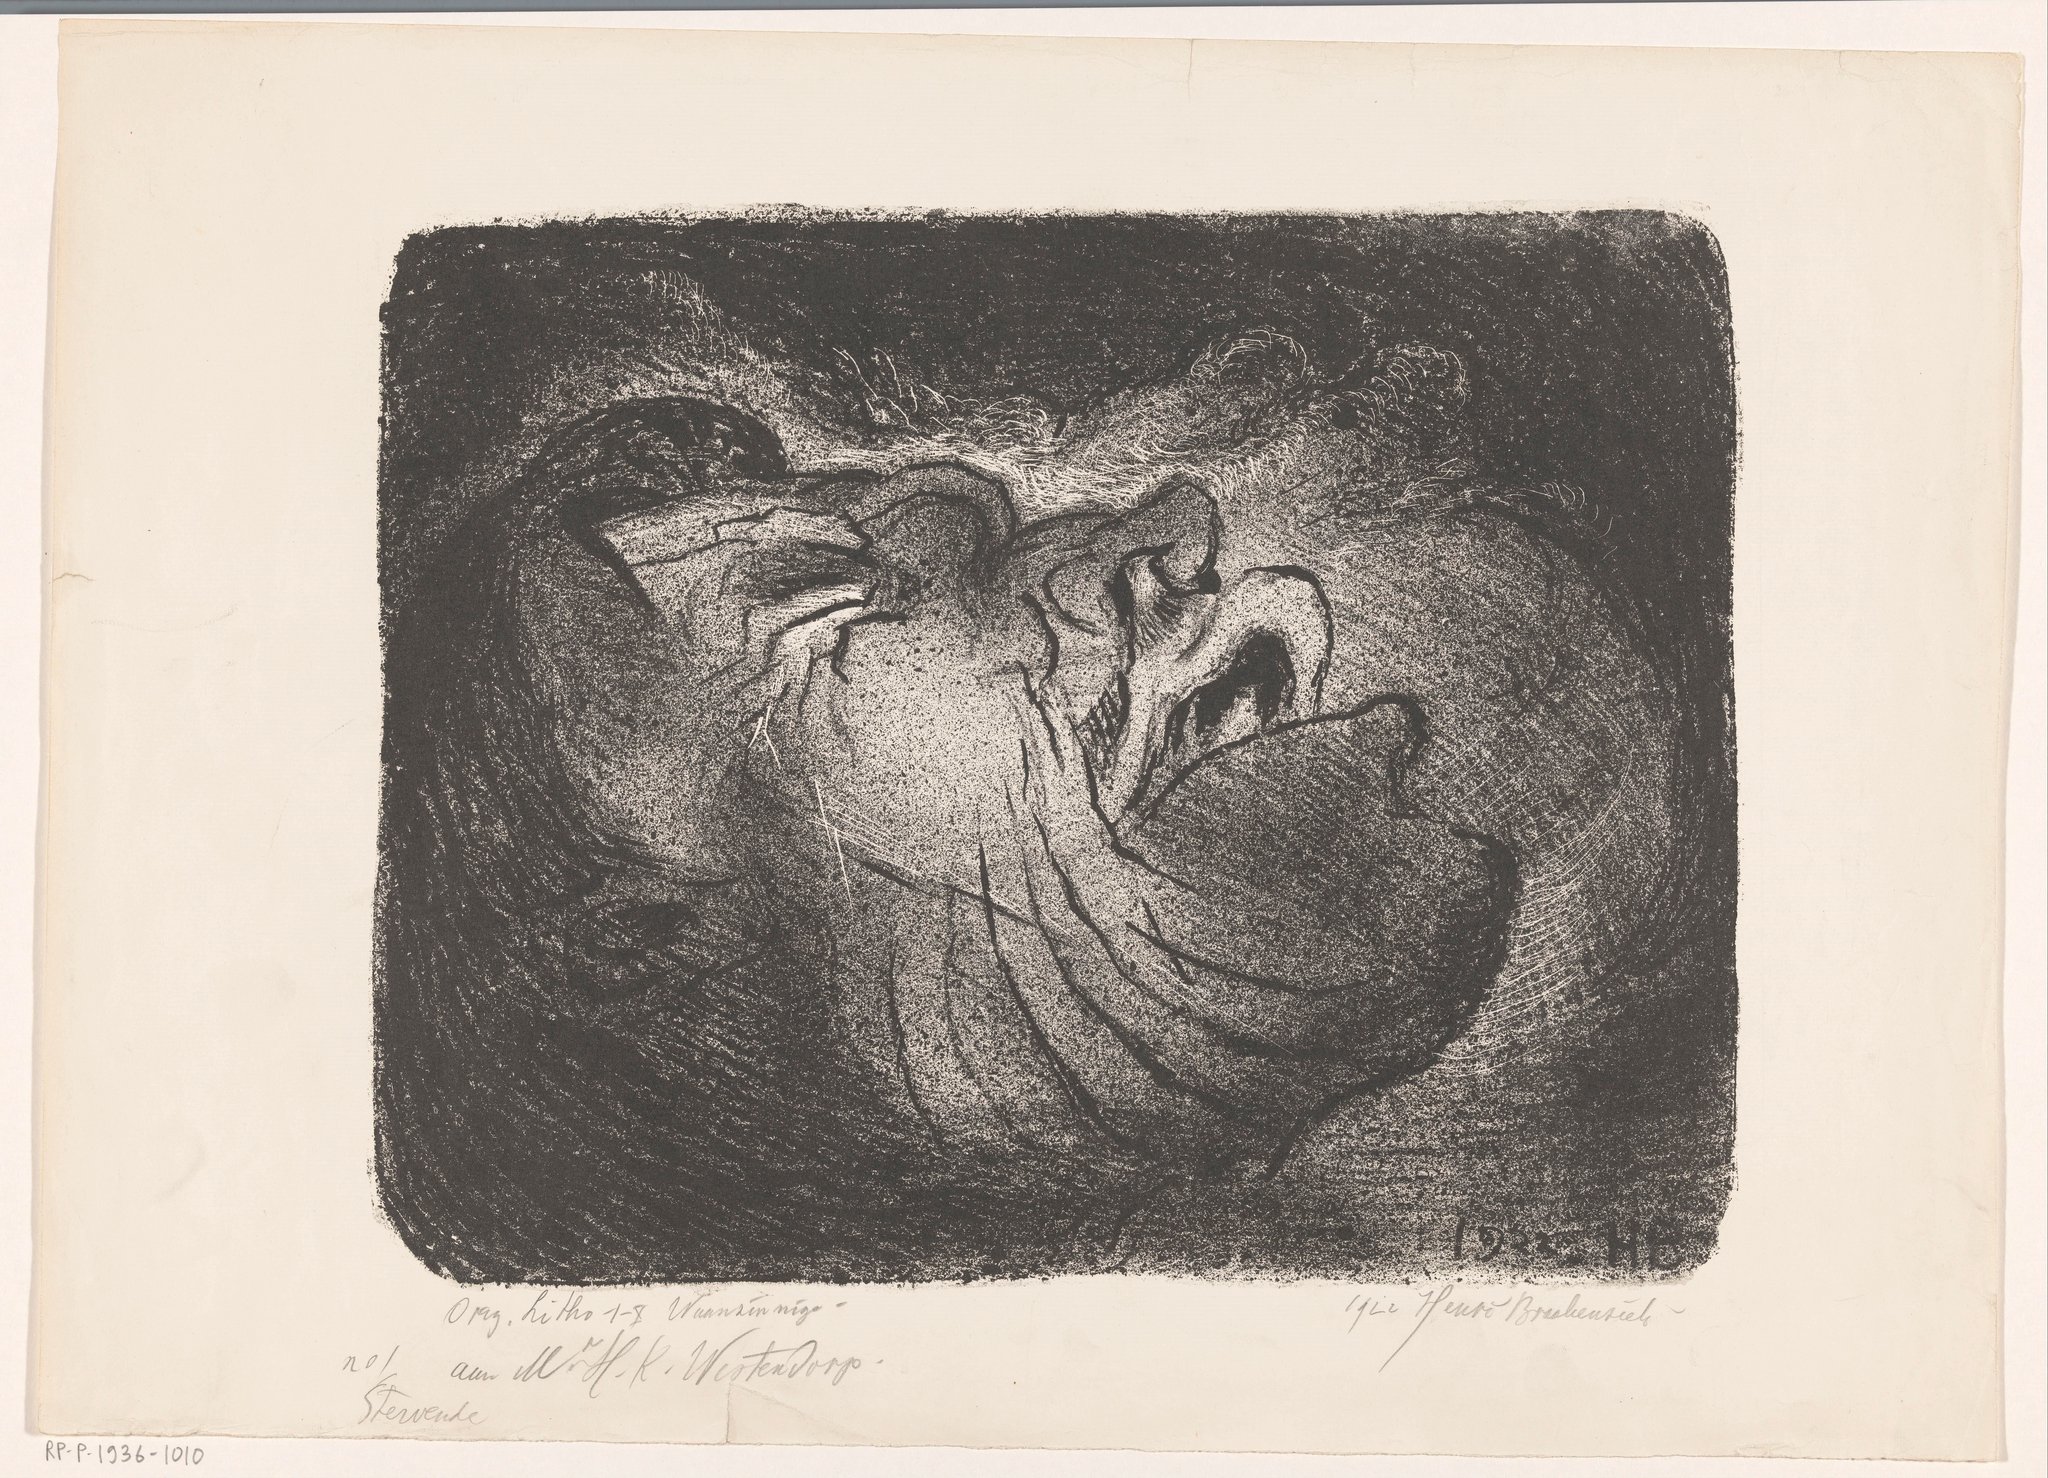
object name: print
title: Waanzinnigen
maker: henri braakensiek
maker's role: print maker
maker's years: 1891-1941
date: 1922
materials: paper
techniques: lithograph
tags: deathbed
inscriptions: inscription: ‘aan Dr. H.K. Westendorp’, collector's mark: Lugt 2228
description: Een liggende man met gesloten ogen en geopende mond.